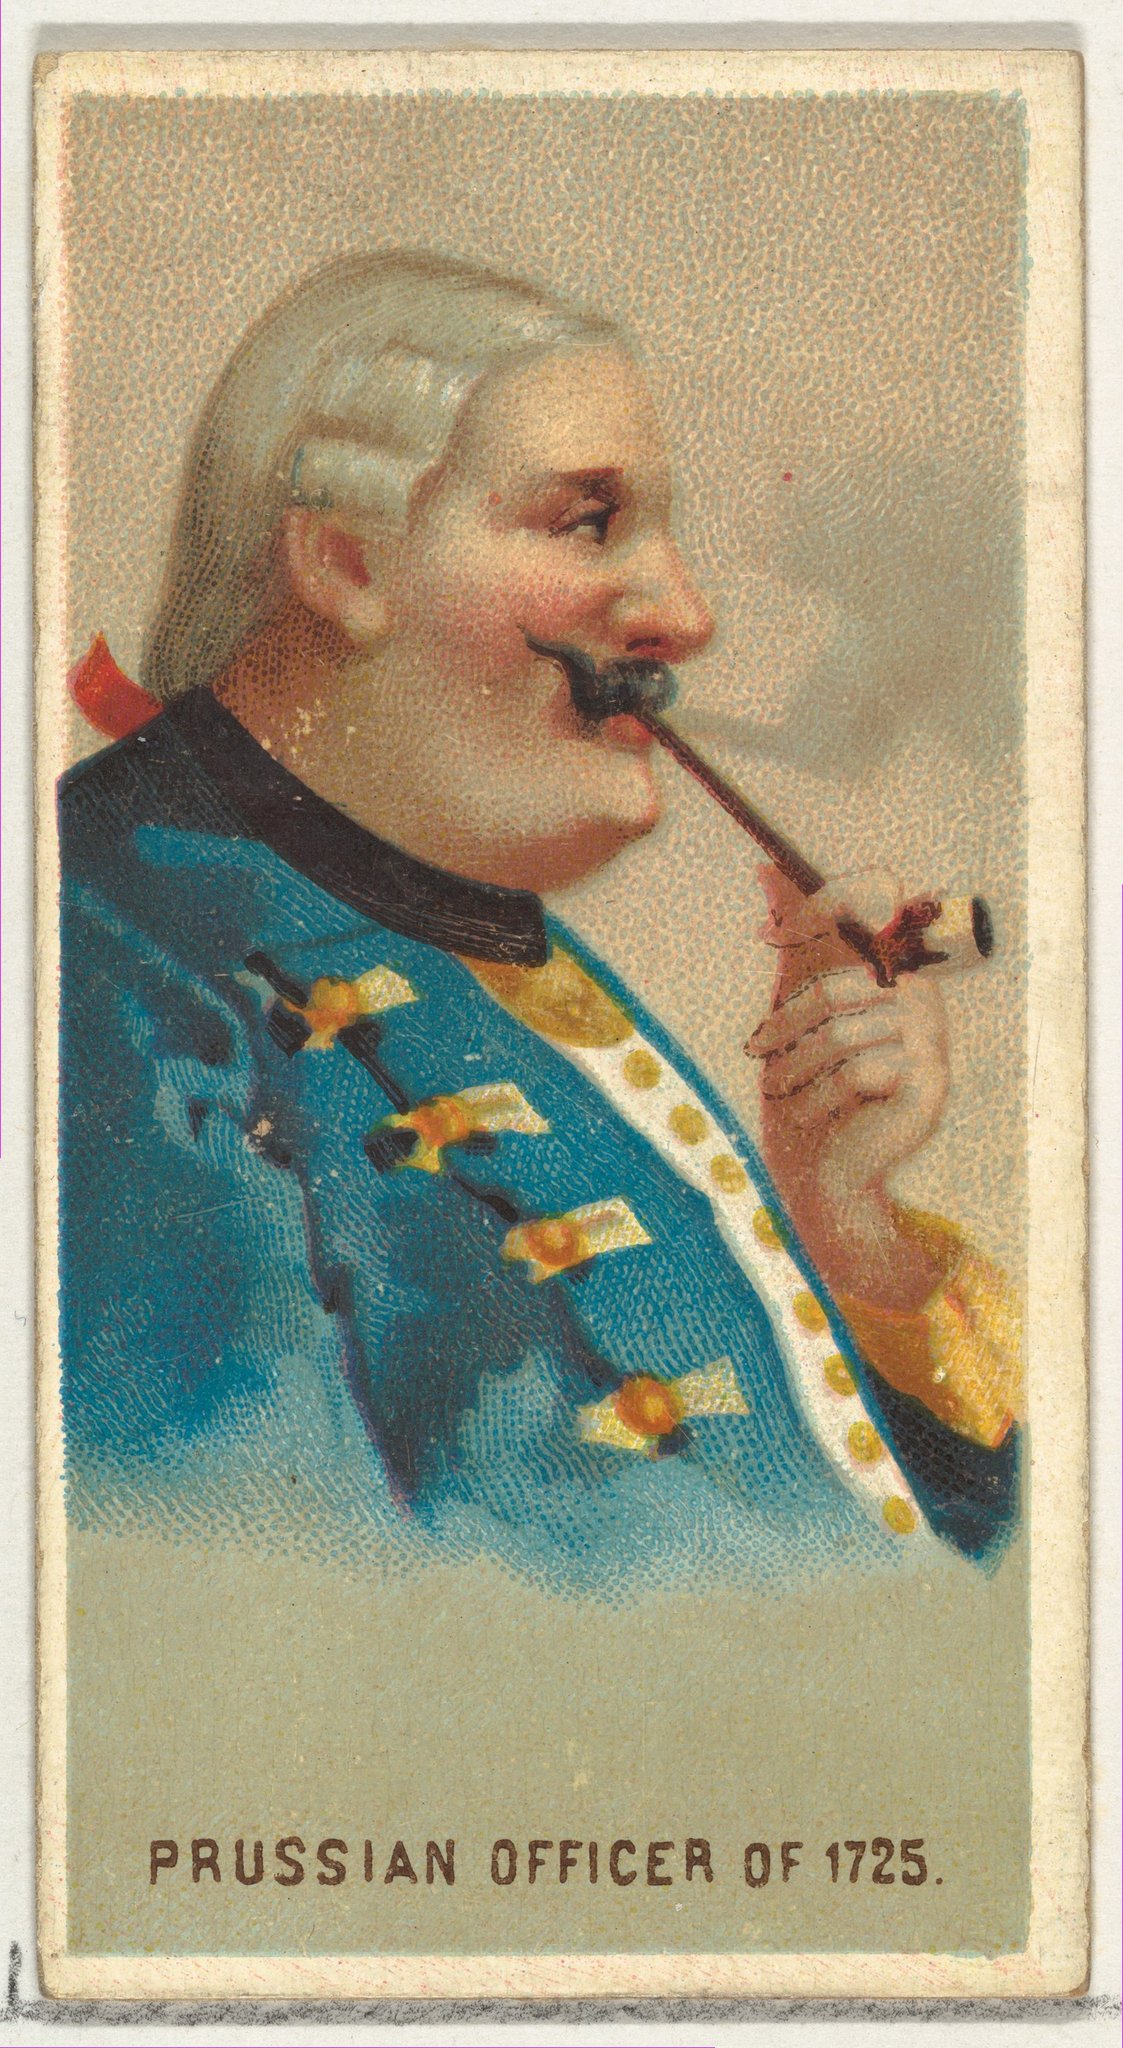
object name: print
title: Prussian Officer of 1725, from World's Smokers series (N33) for Allen & Ginter Cigarettes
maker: allen & ginter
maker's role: publisher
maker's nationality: american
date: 1888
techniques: color lithograph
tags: men,profiles,smoking